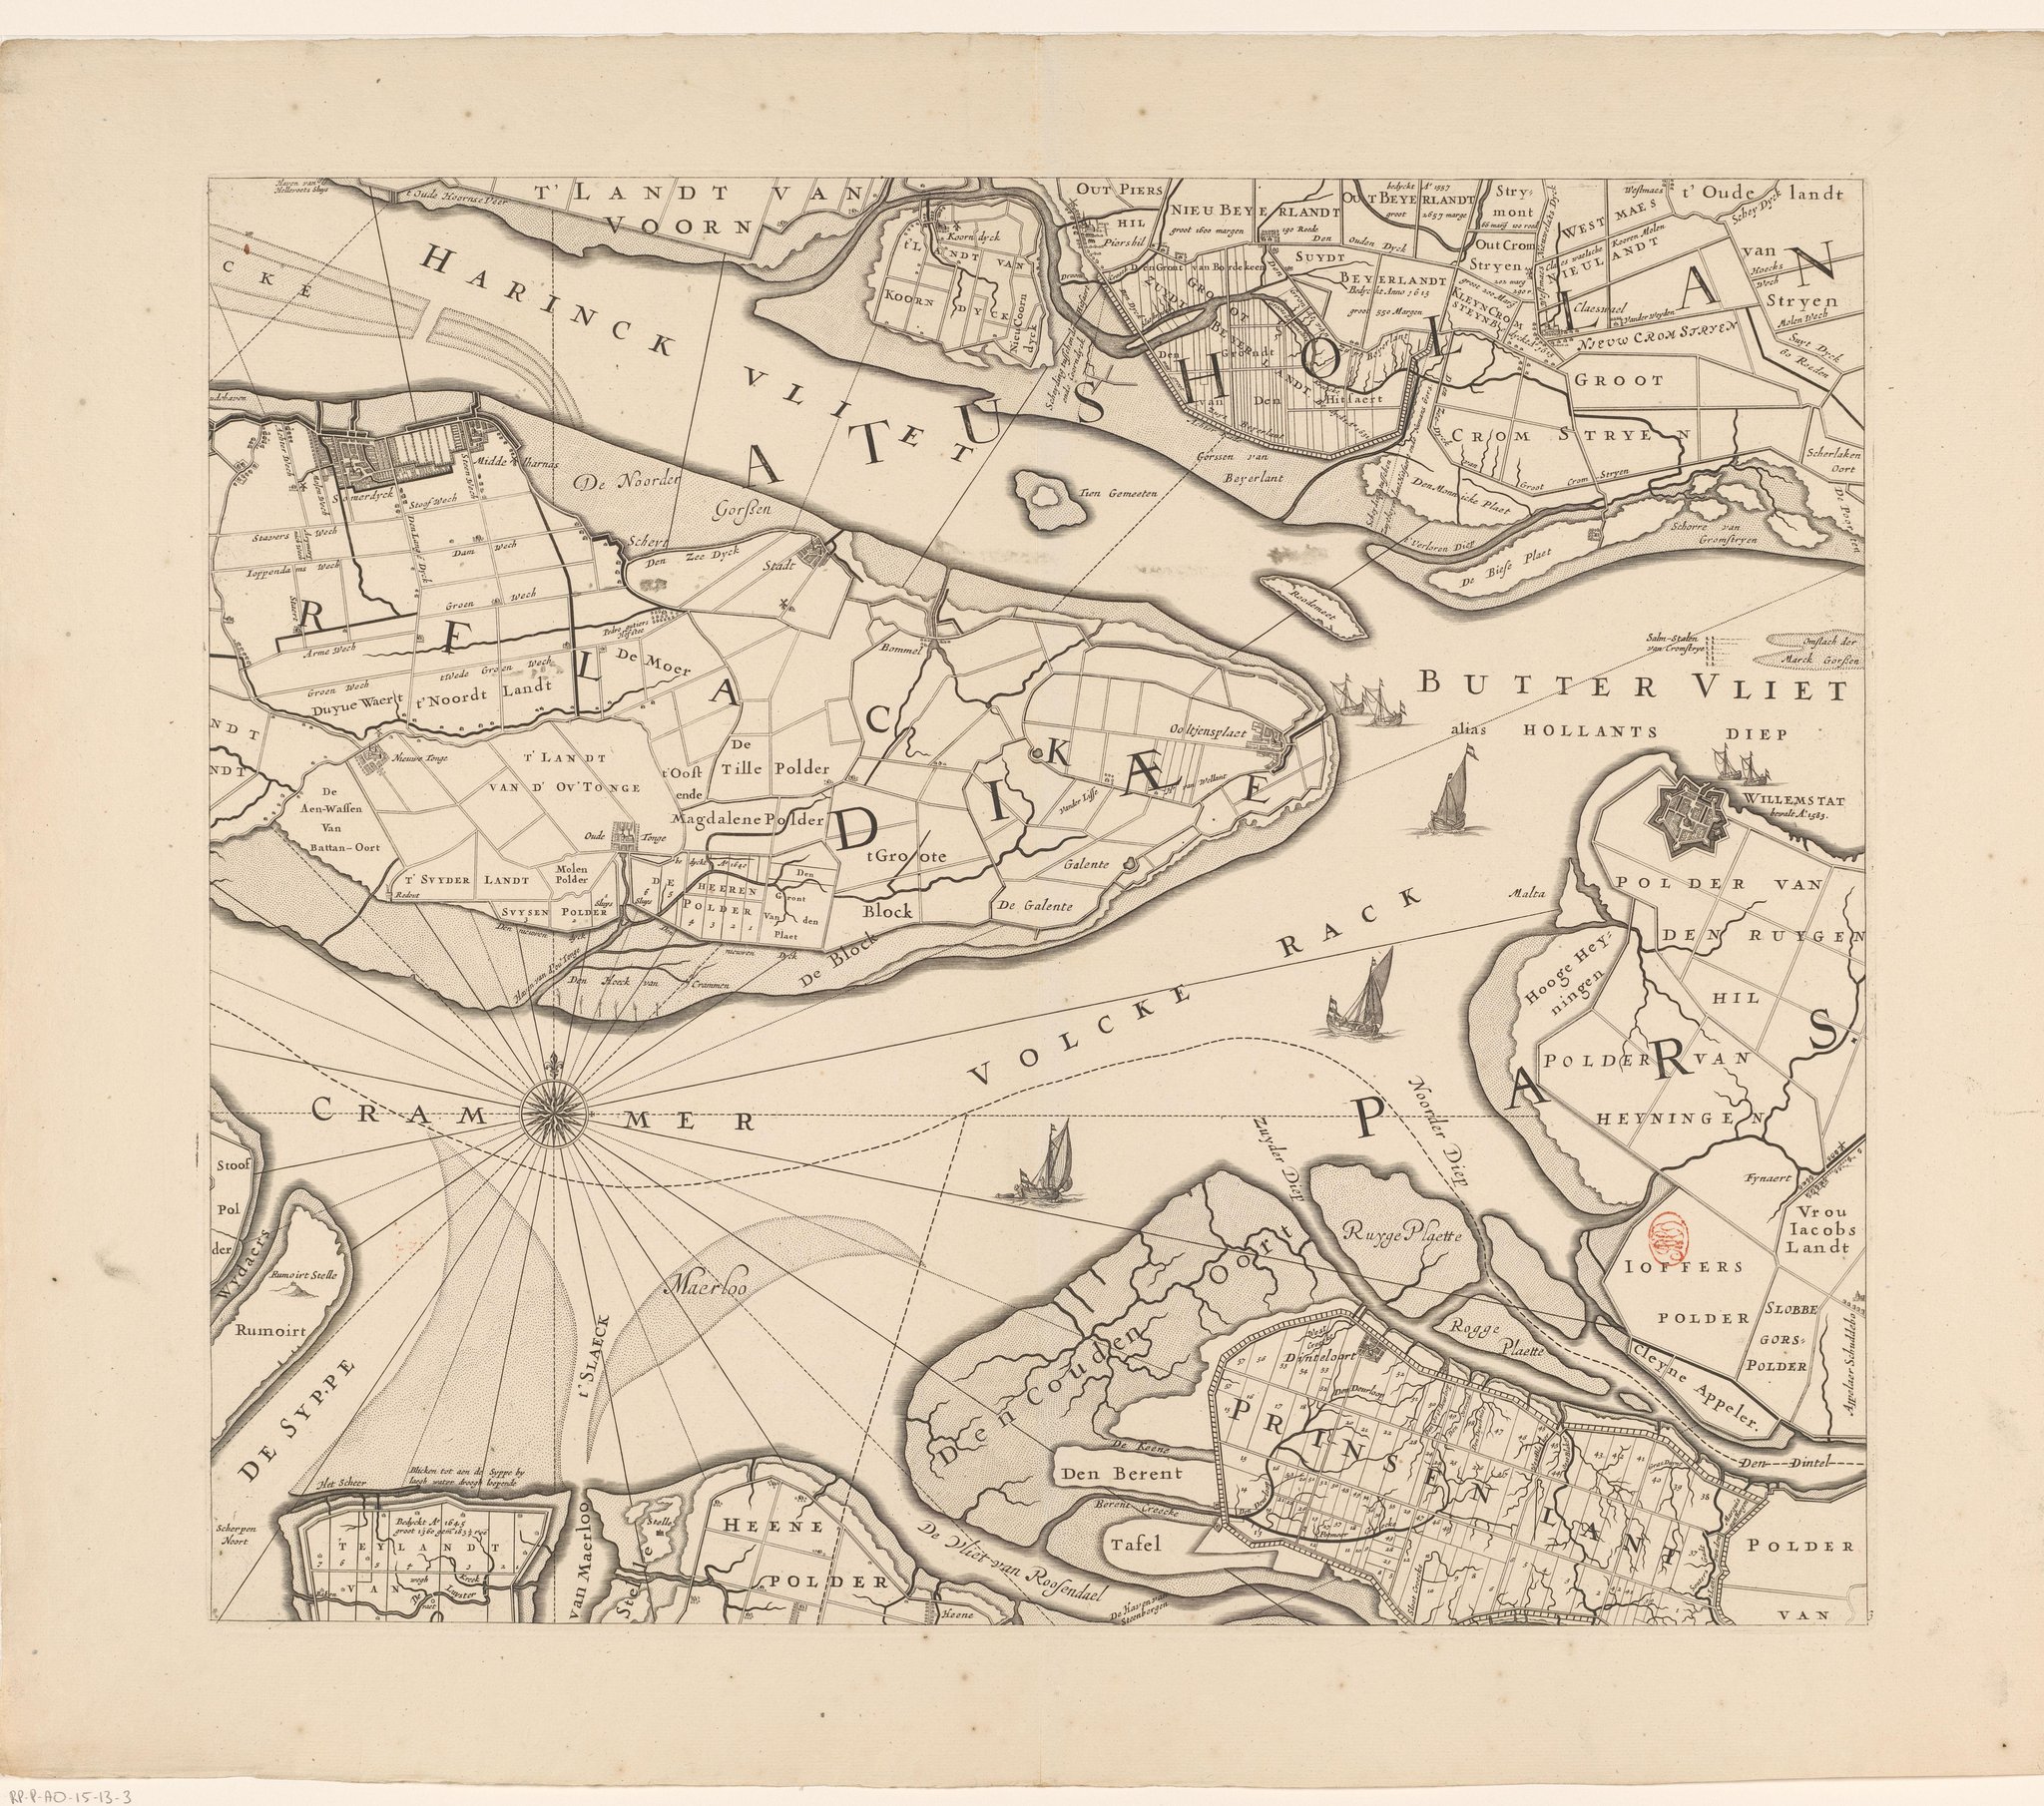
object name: print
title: Kaart van Zeeland (derde deel)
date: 1655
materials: paper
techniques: engraving, etching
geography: amsterdam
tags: maps of separate countries or regions, zeeland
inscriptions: collector's mark: Lugt 195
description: Derde deel van een kaart van Zeeland, bestaande uit negen delen. Rechtsonder genummerd: 3.